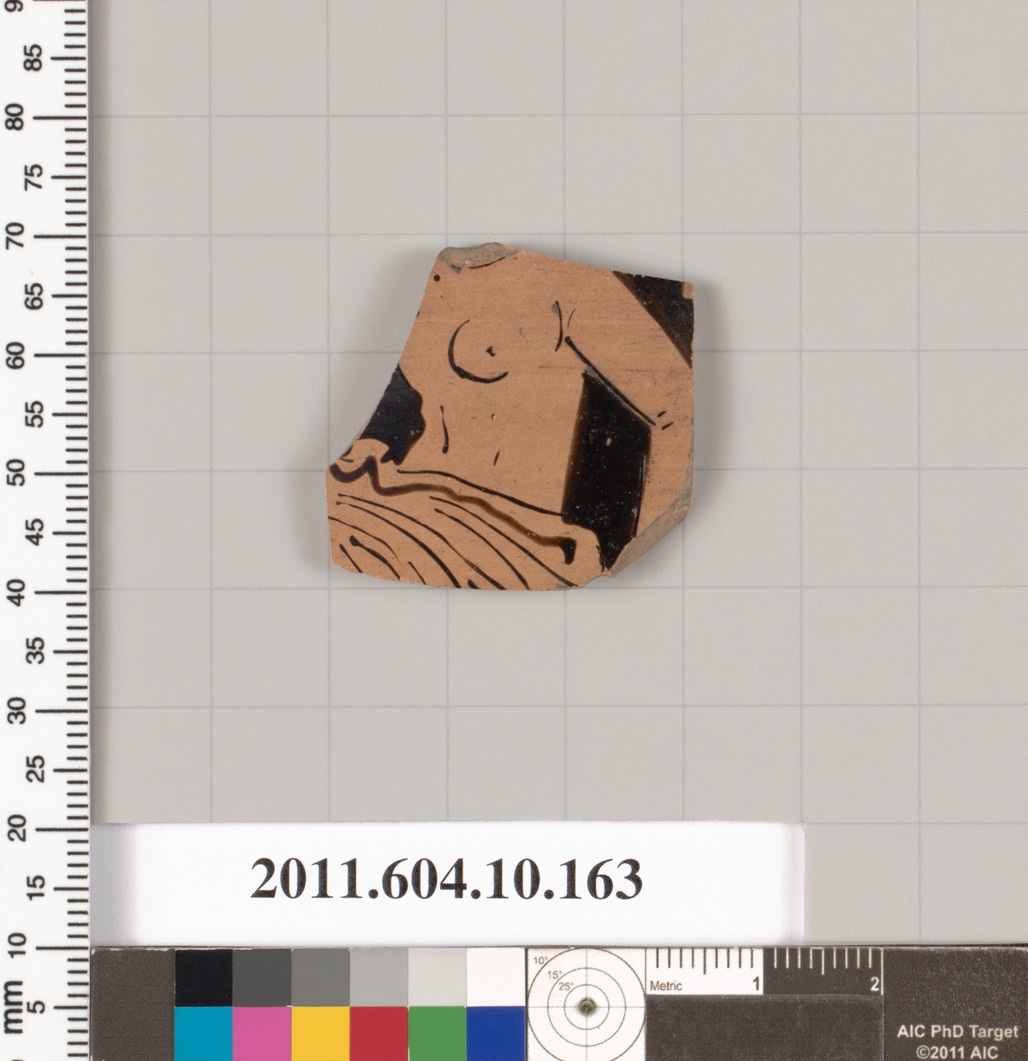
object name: skyphos fragment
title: Terracotta fragment of a skyphos (deep drinking cup)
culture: etruscan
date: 434-368 BCE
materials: terracotta